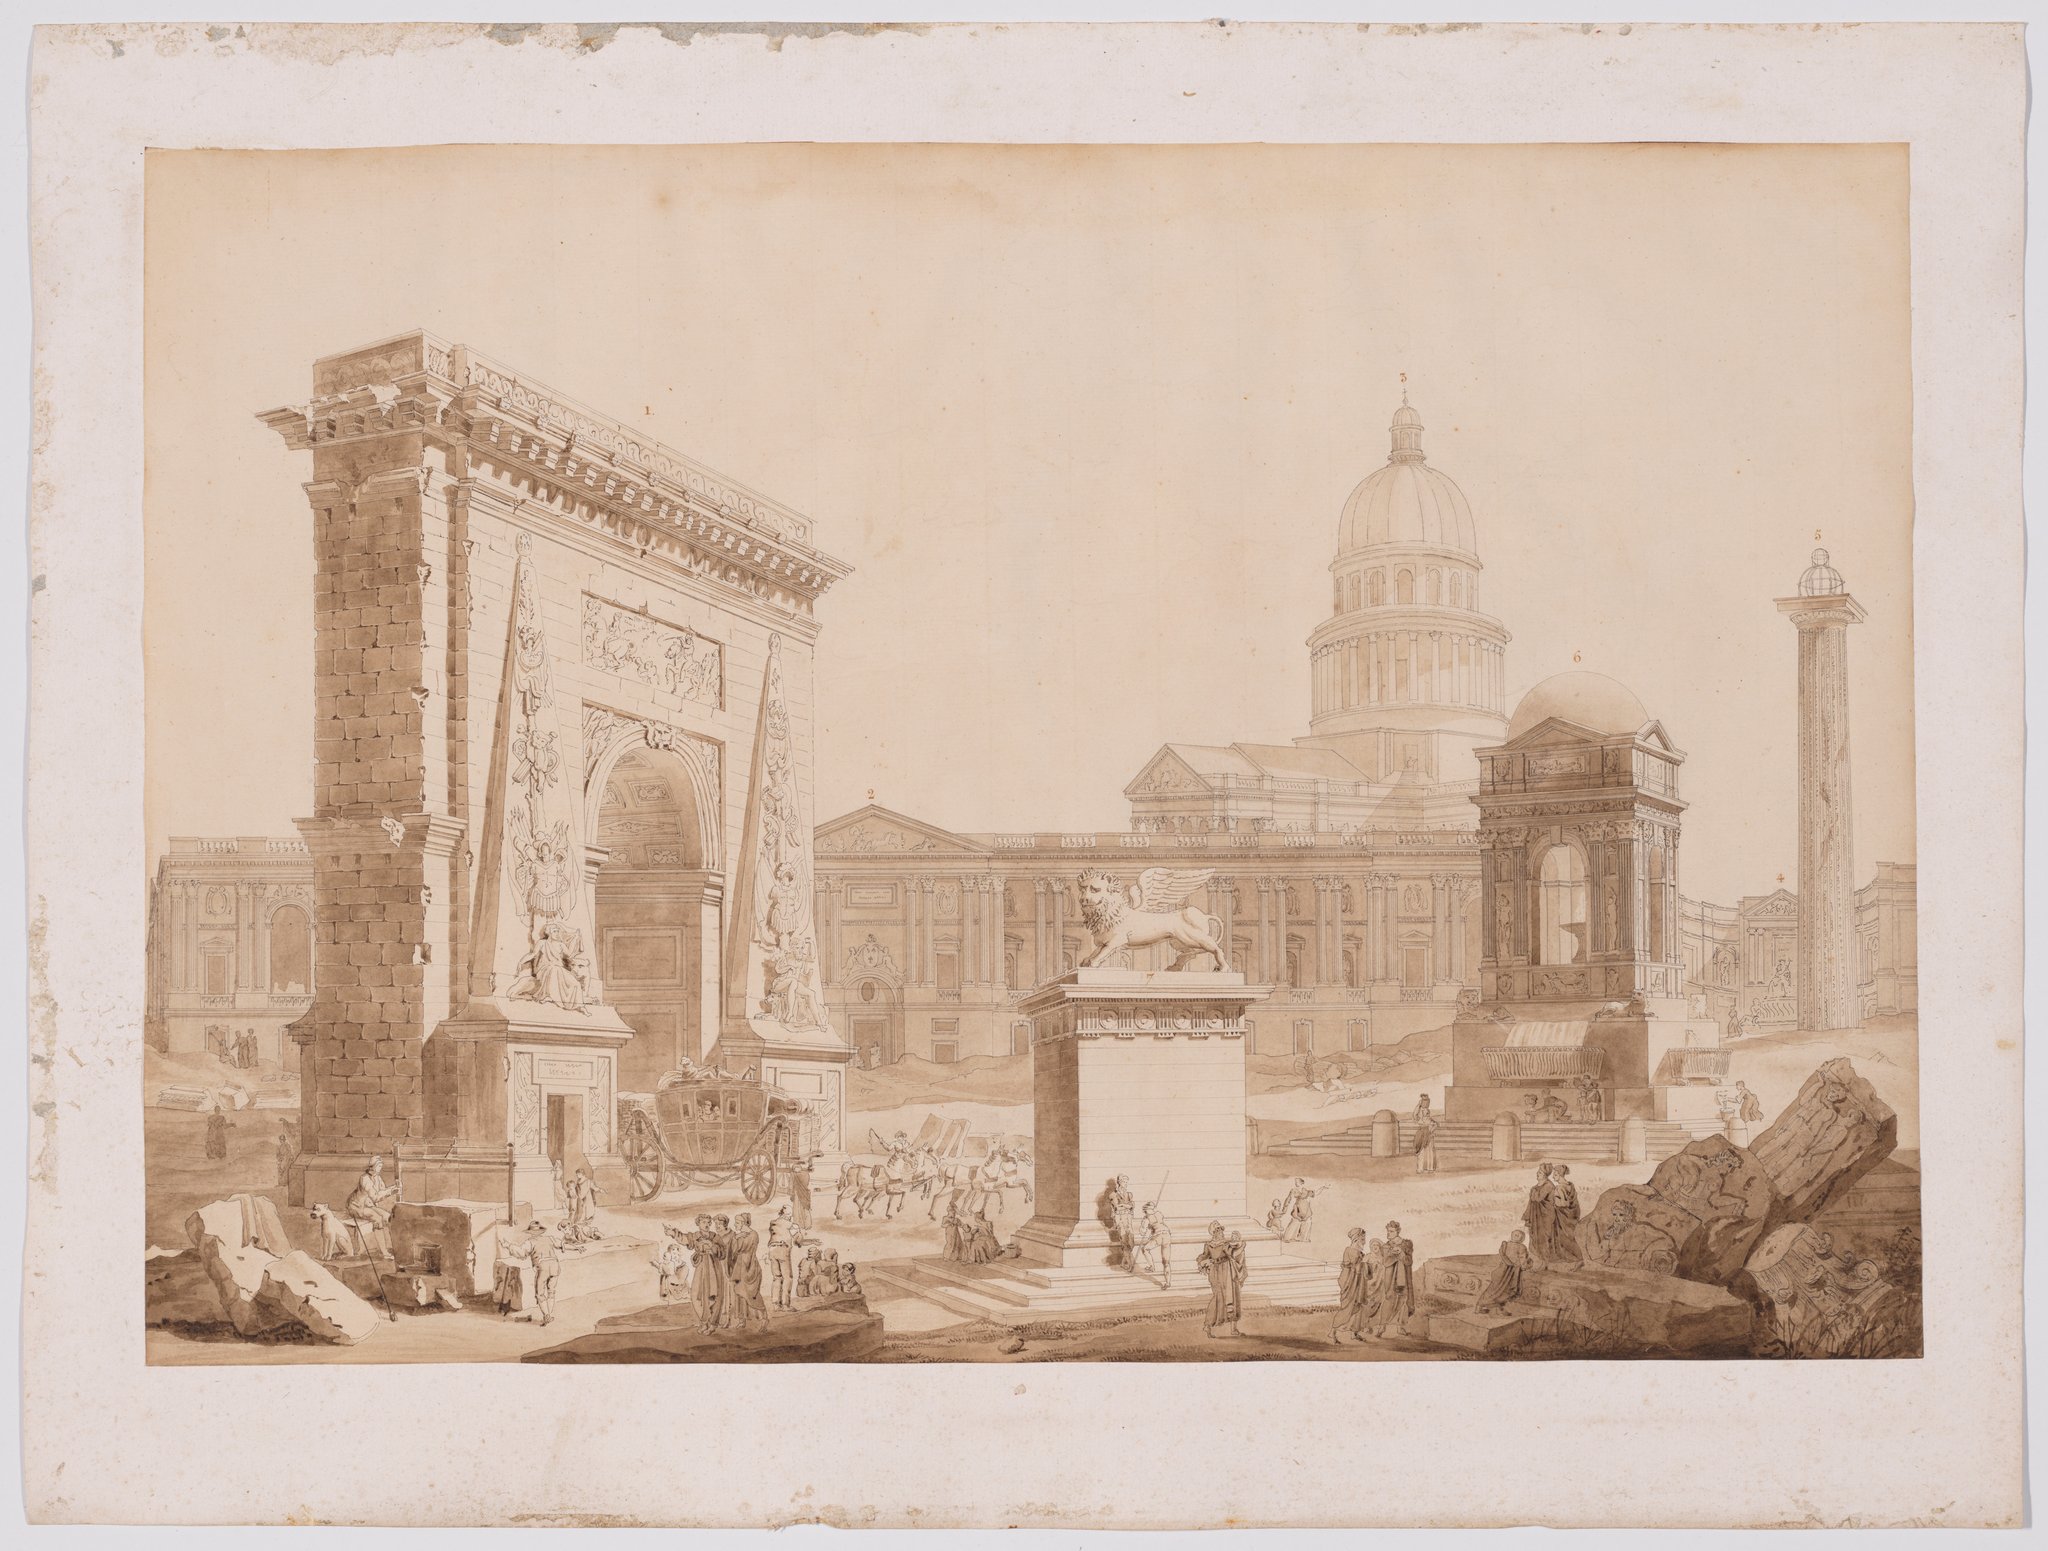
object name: print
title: The Monuments of Paris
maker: régine carey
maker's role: artist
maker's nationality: german, born nuremberg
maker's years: 1760-1821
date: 1806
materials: ink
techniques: brush, pen, wash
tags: paris